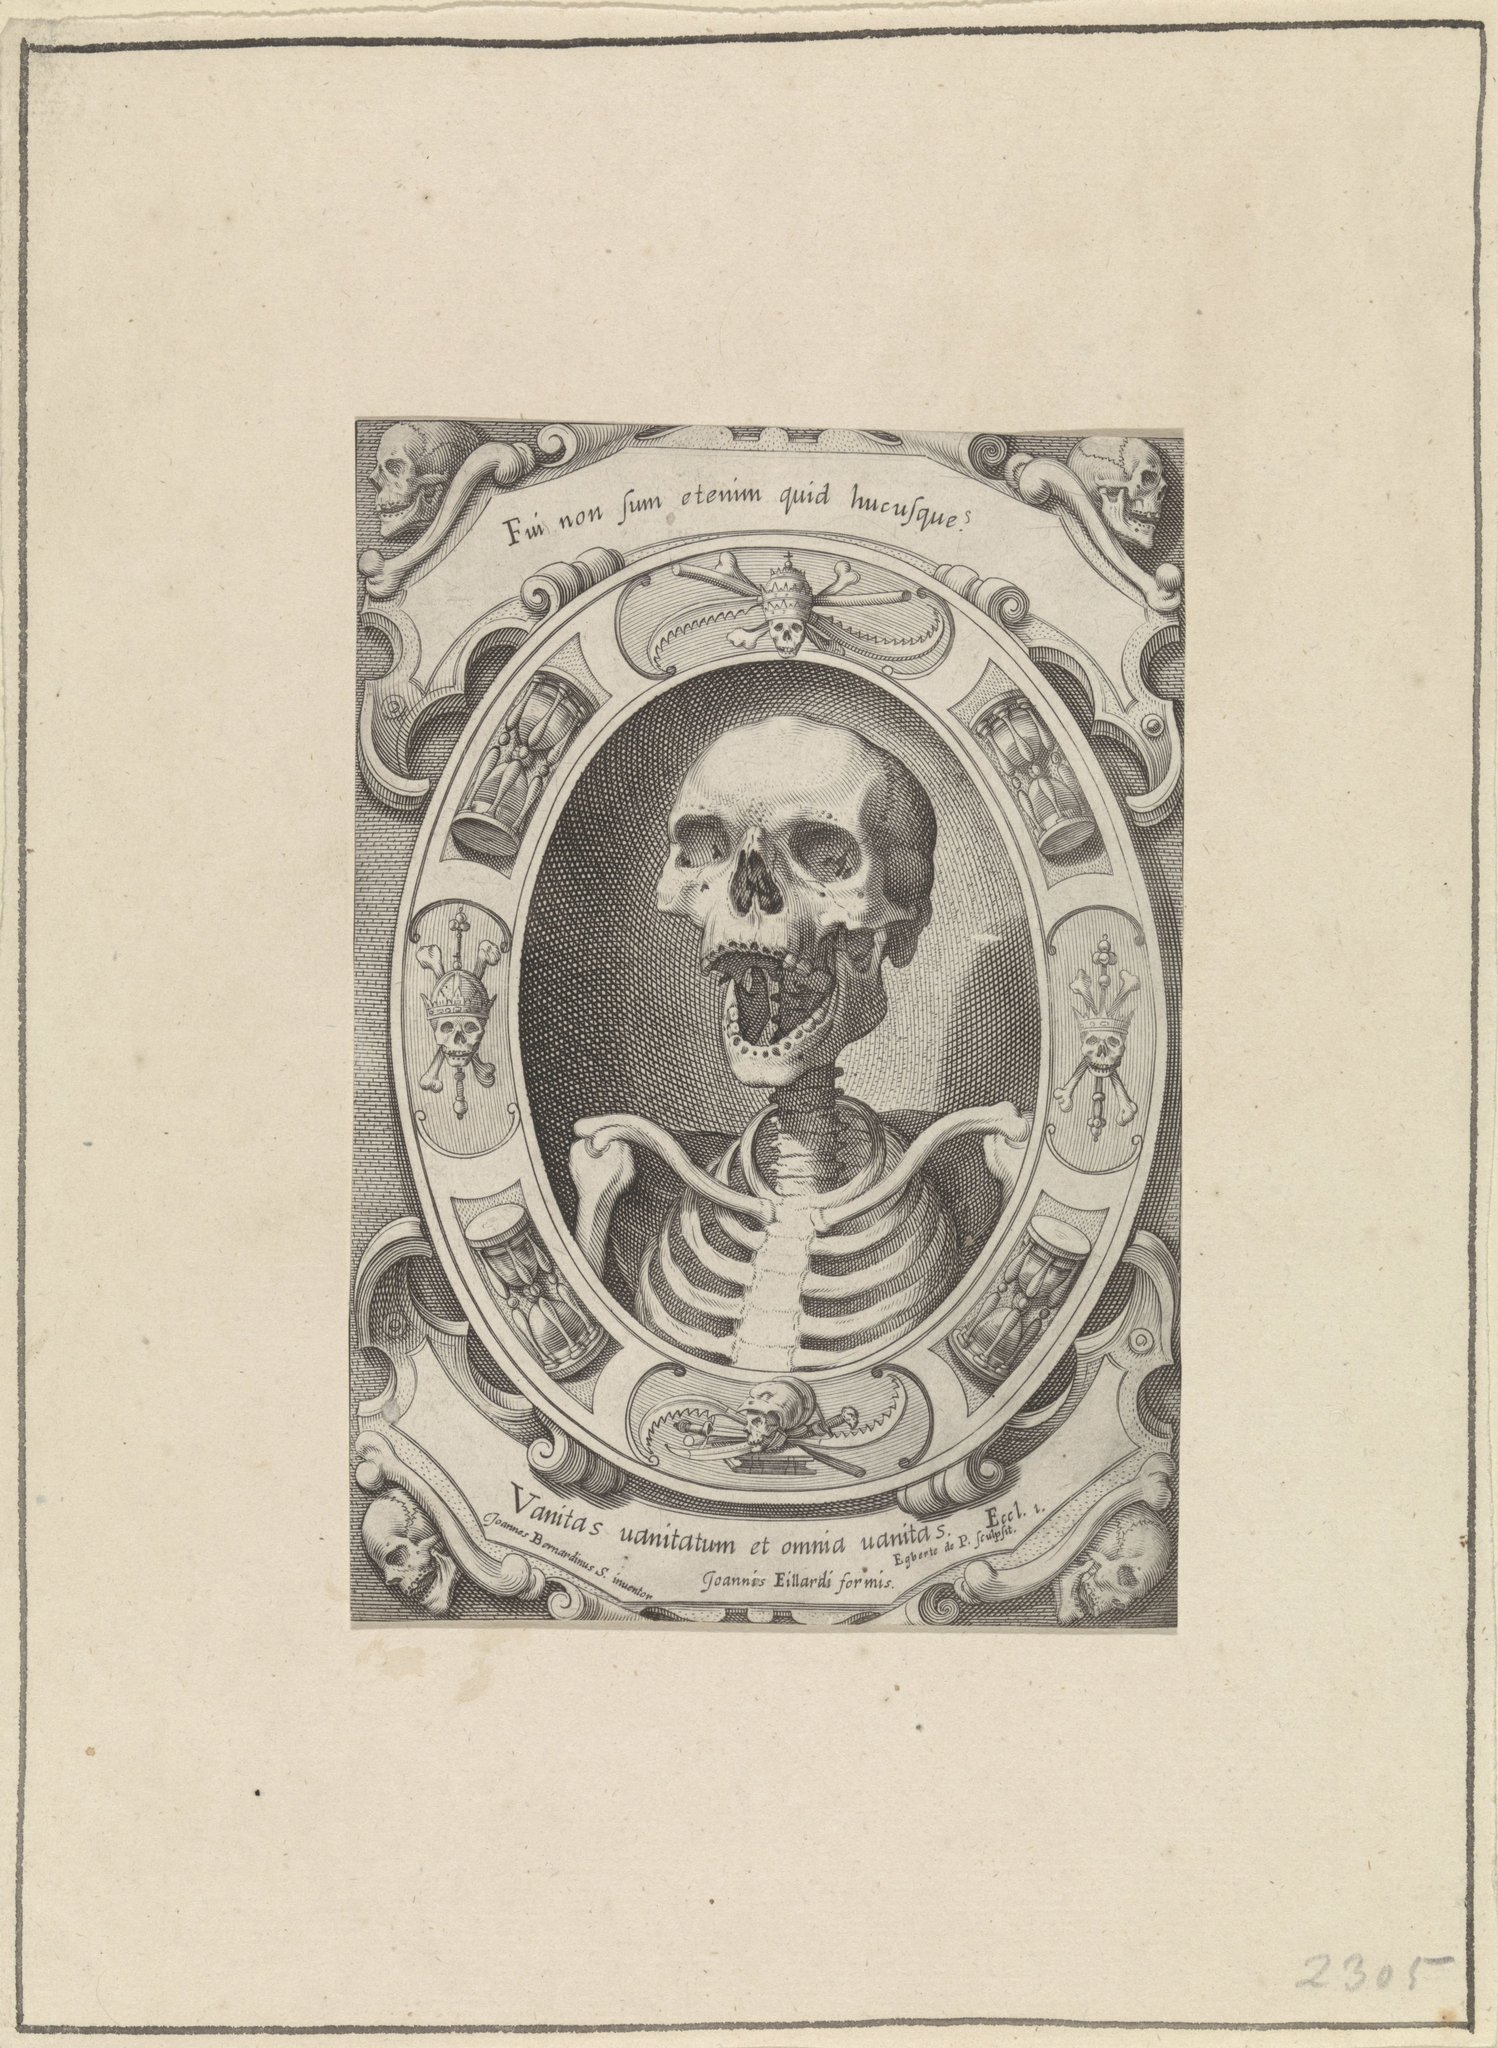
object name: print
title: Skeletbuste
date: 1590-1637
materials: paper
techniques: engraving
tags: 'vanitas' symbols, skull as symbol of 'vanitas'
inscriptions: collector's mark: Lugt 2228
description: Skeletbuste, met opengesperde mond, naar links. De buste is gevat in een ovale omlijsting met Vanitassymbolen. Boven de omlijsting in een cartouche een bovenschift in het Latijn. Onder de omlijsting in een cartouche een onderschrift uit Prediker in het Latijn.